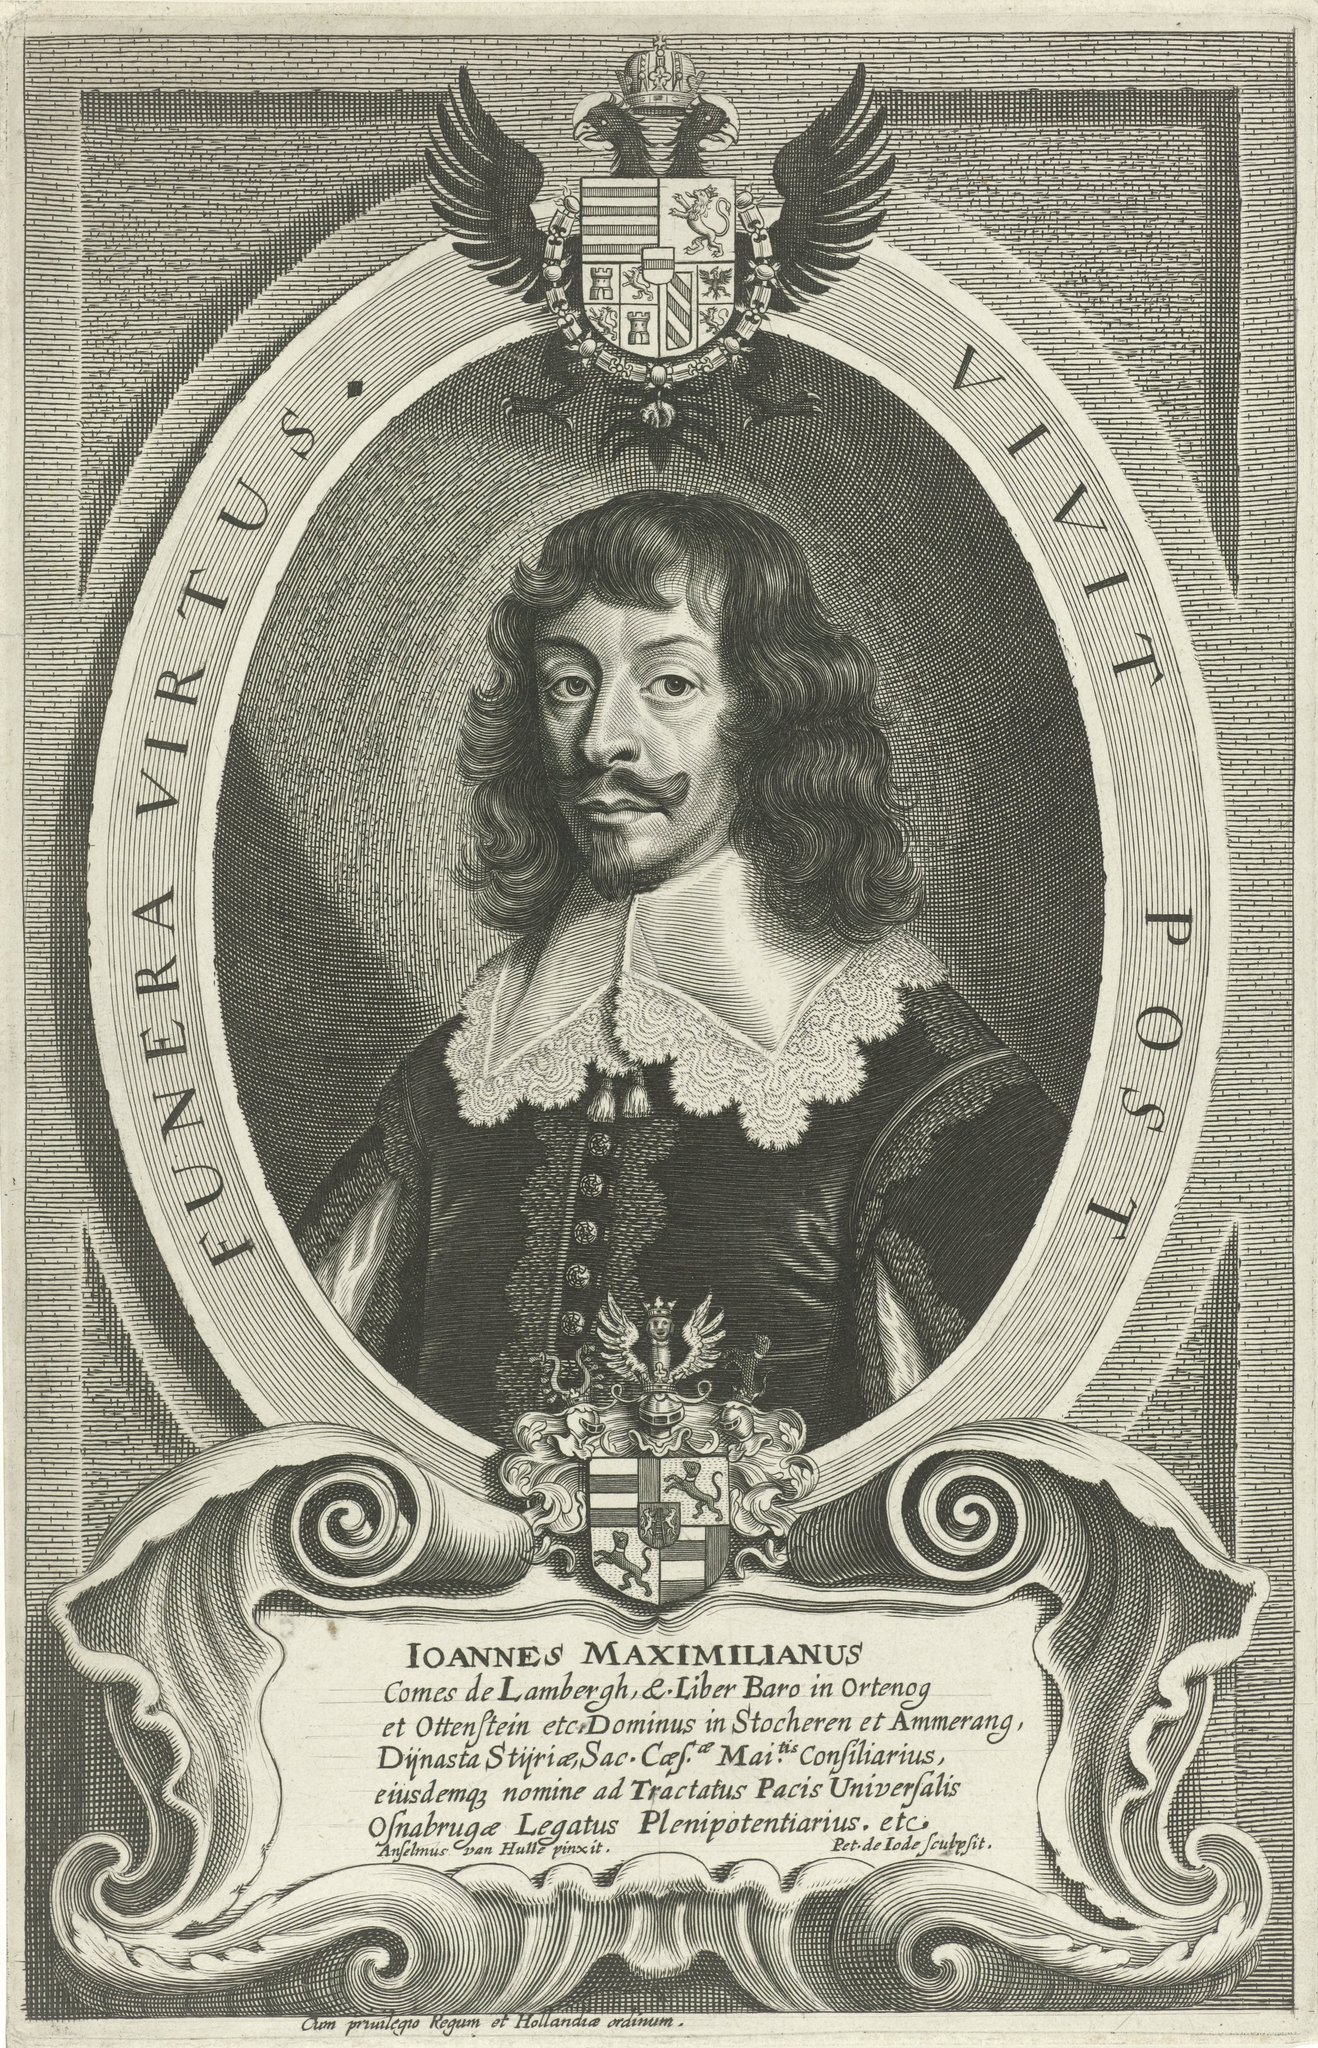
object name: print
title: Portret van Johann Maximilian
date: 1628-1670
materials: paper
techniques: engraving, etching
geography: antwerp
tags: vienna, knighthood order of the golden fleece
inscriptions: collector's mark: Lugt 2228, collector's mark: Lugt 2507, collector's mark: Lugt 2318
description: Busteportret van Johann Maximilian, graaf van Lamberg. Het portret is gevat in een ovale omlijsting met het wapenschild van de geportretteerde, een keten met de Orde van het Gulden Vlies en een randschrift in het Latijn. In de cartouche een zesregelig onderschrift in het Latijn. Prent uit een serie portretten naar schilderijen van Anselmus van Hulle van alle gedelegeerden bij de vredesonderhandelingen te Münster en Osnabrück.